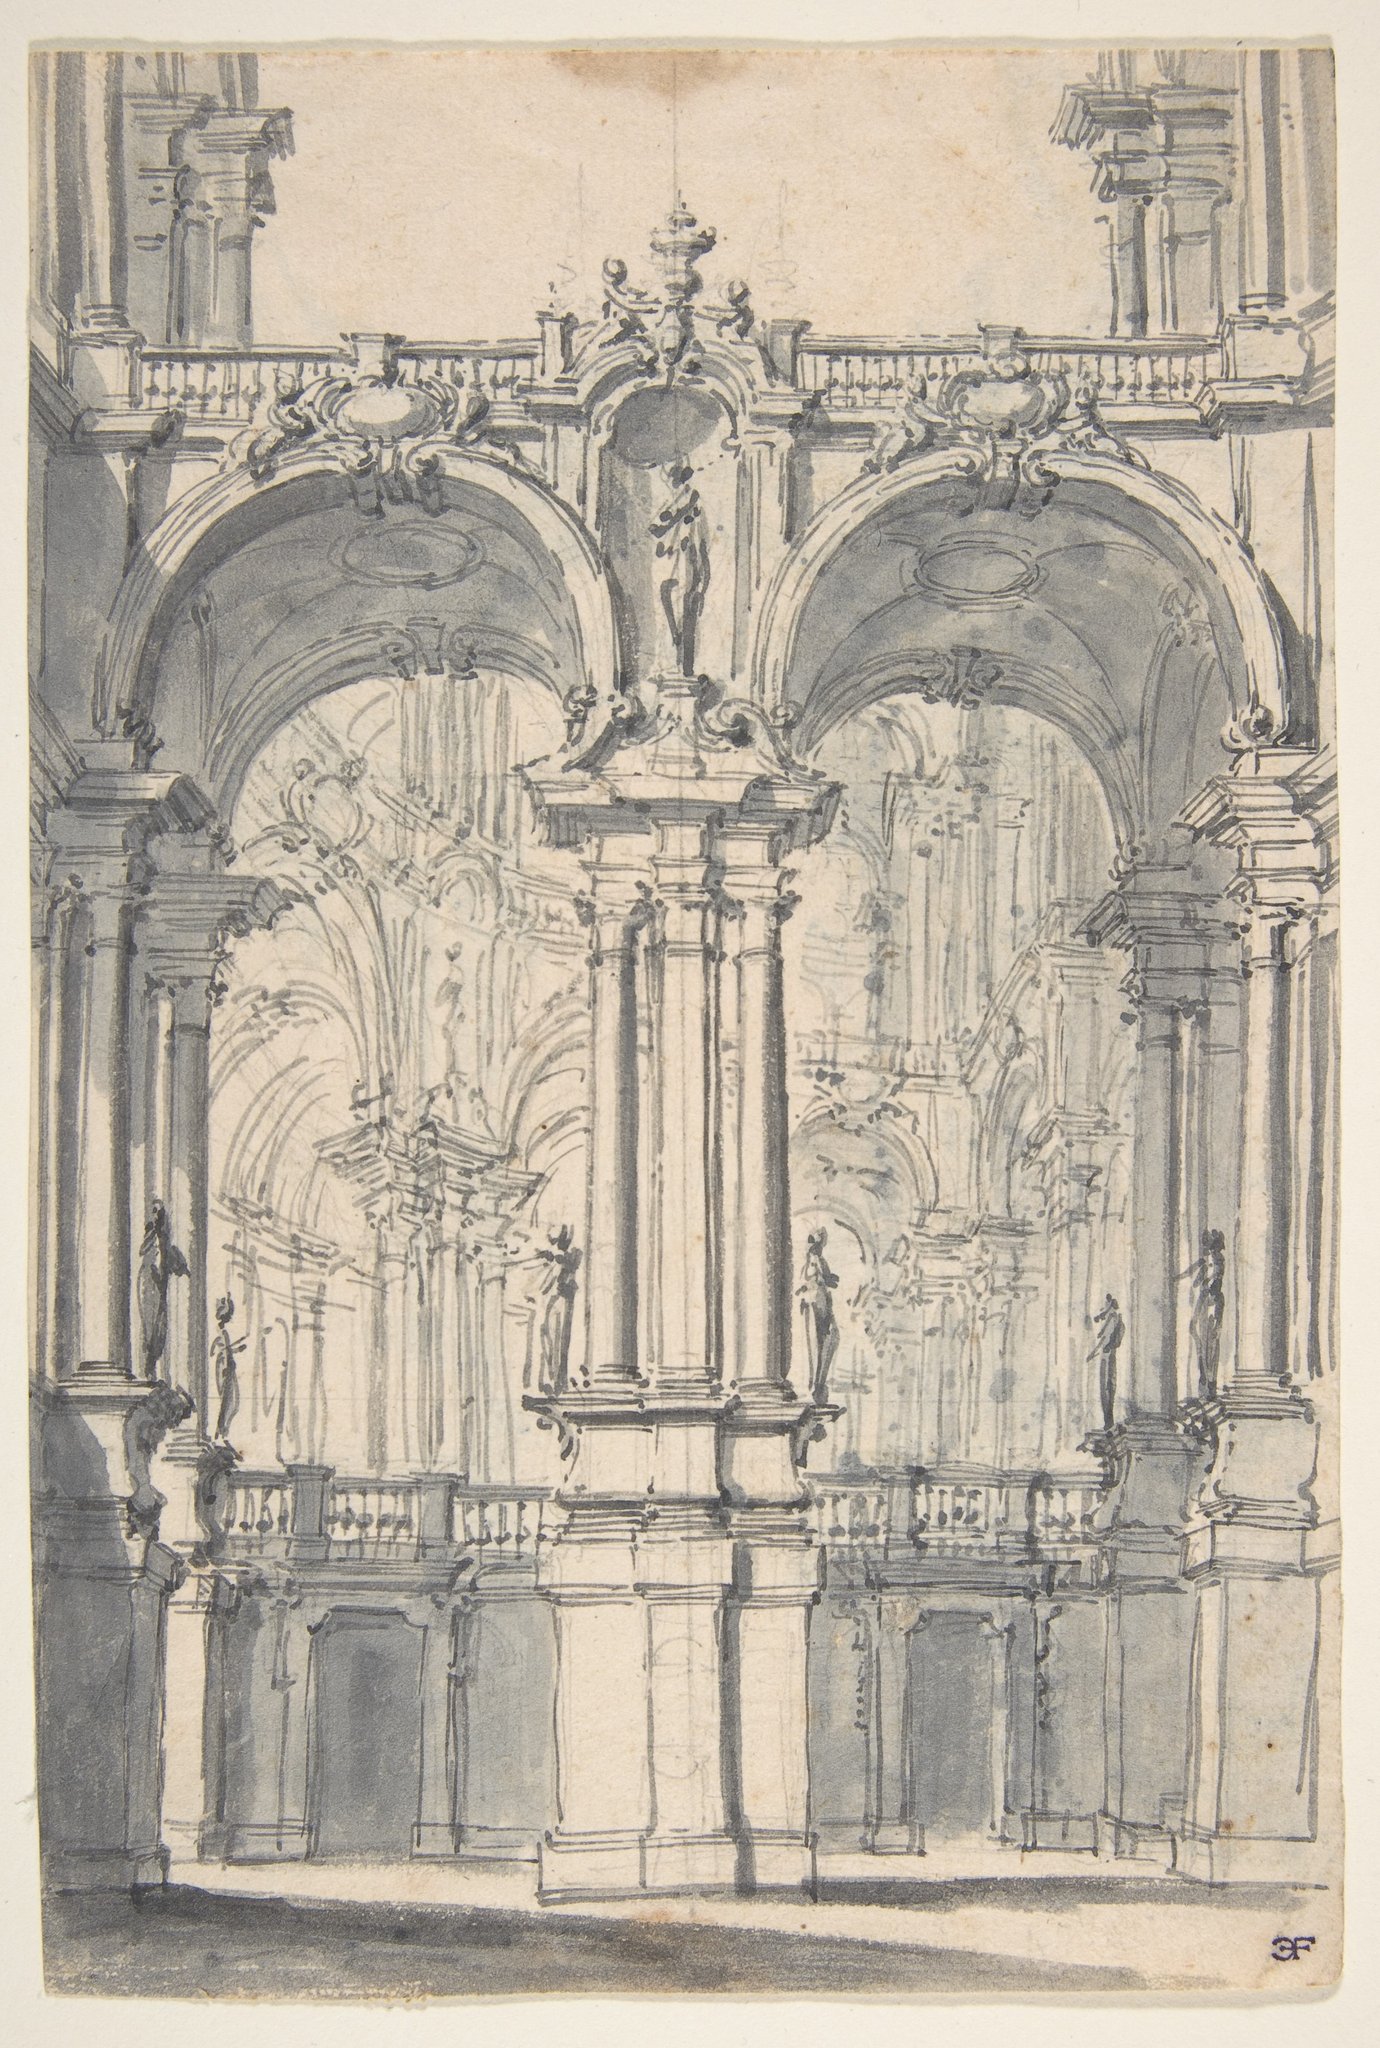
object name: drawing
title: Design for Stage Set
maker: giovanni battista natali iii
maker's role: artist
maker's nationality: italian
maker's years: 1698-1765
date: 1698-1765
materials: ink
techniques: brush, pen, wash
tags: arches,columns,stage design